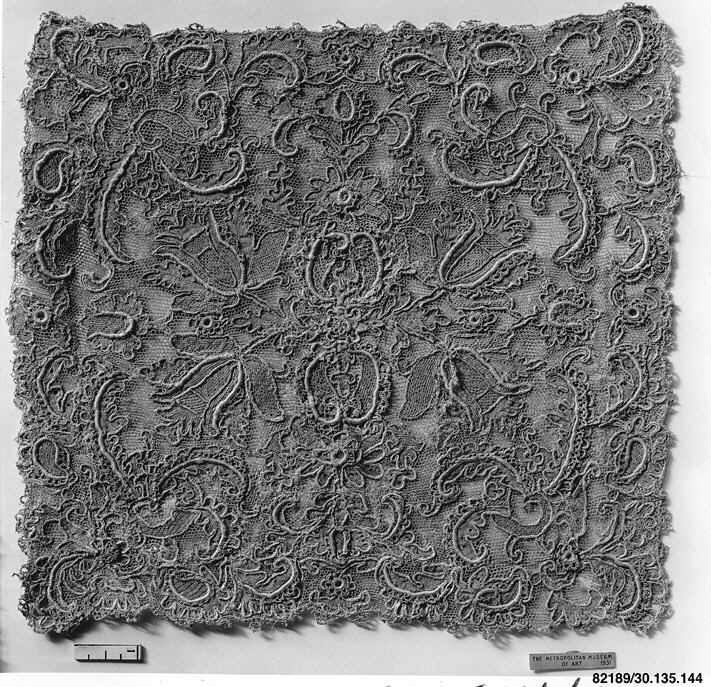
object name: panel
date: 1701-1733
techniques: lace